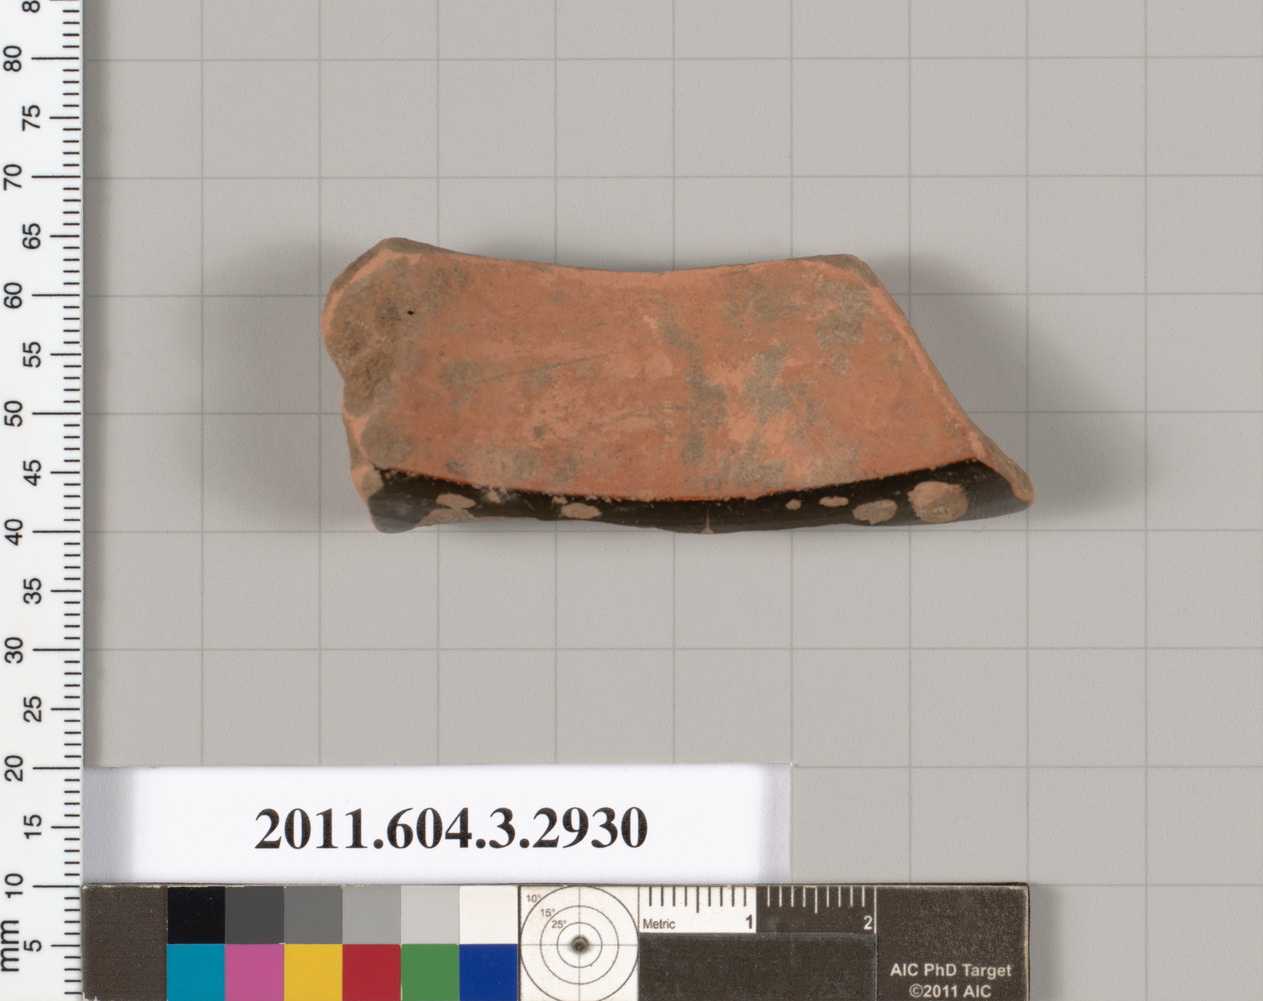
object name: undetermined open shape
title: Terracotta fragment of an open shape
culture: greek, attic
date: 600-401 BCE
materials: terracotta